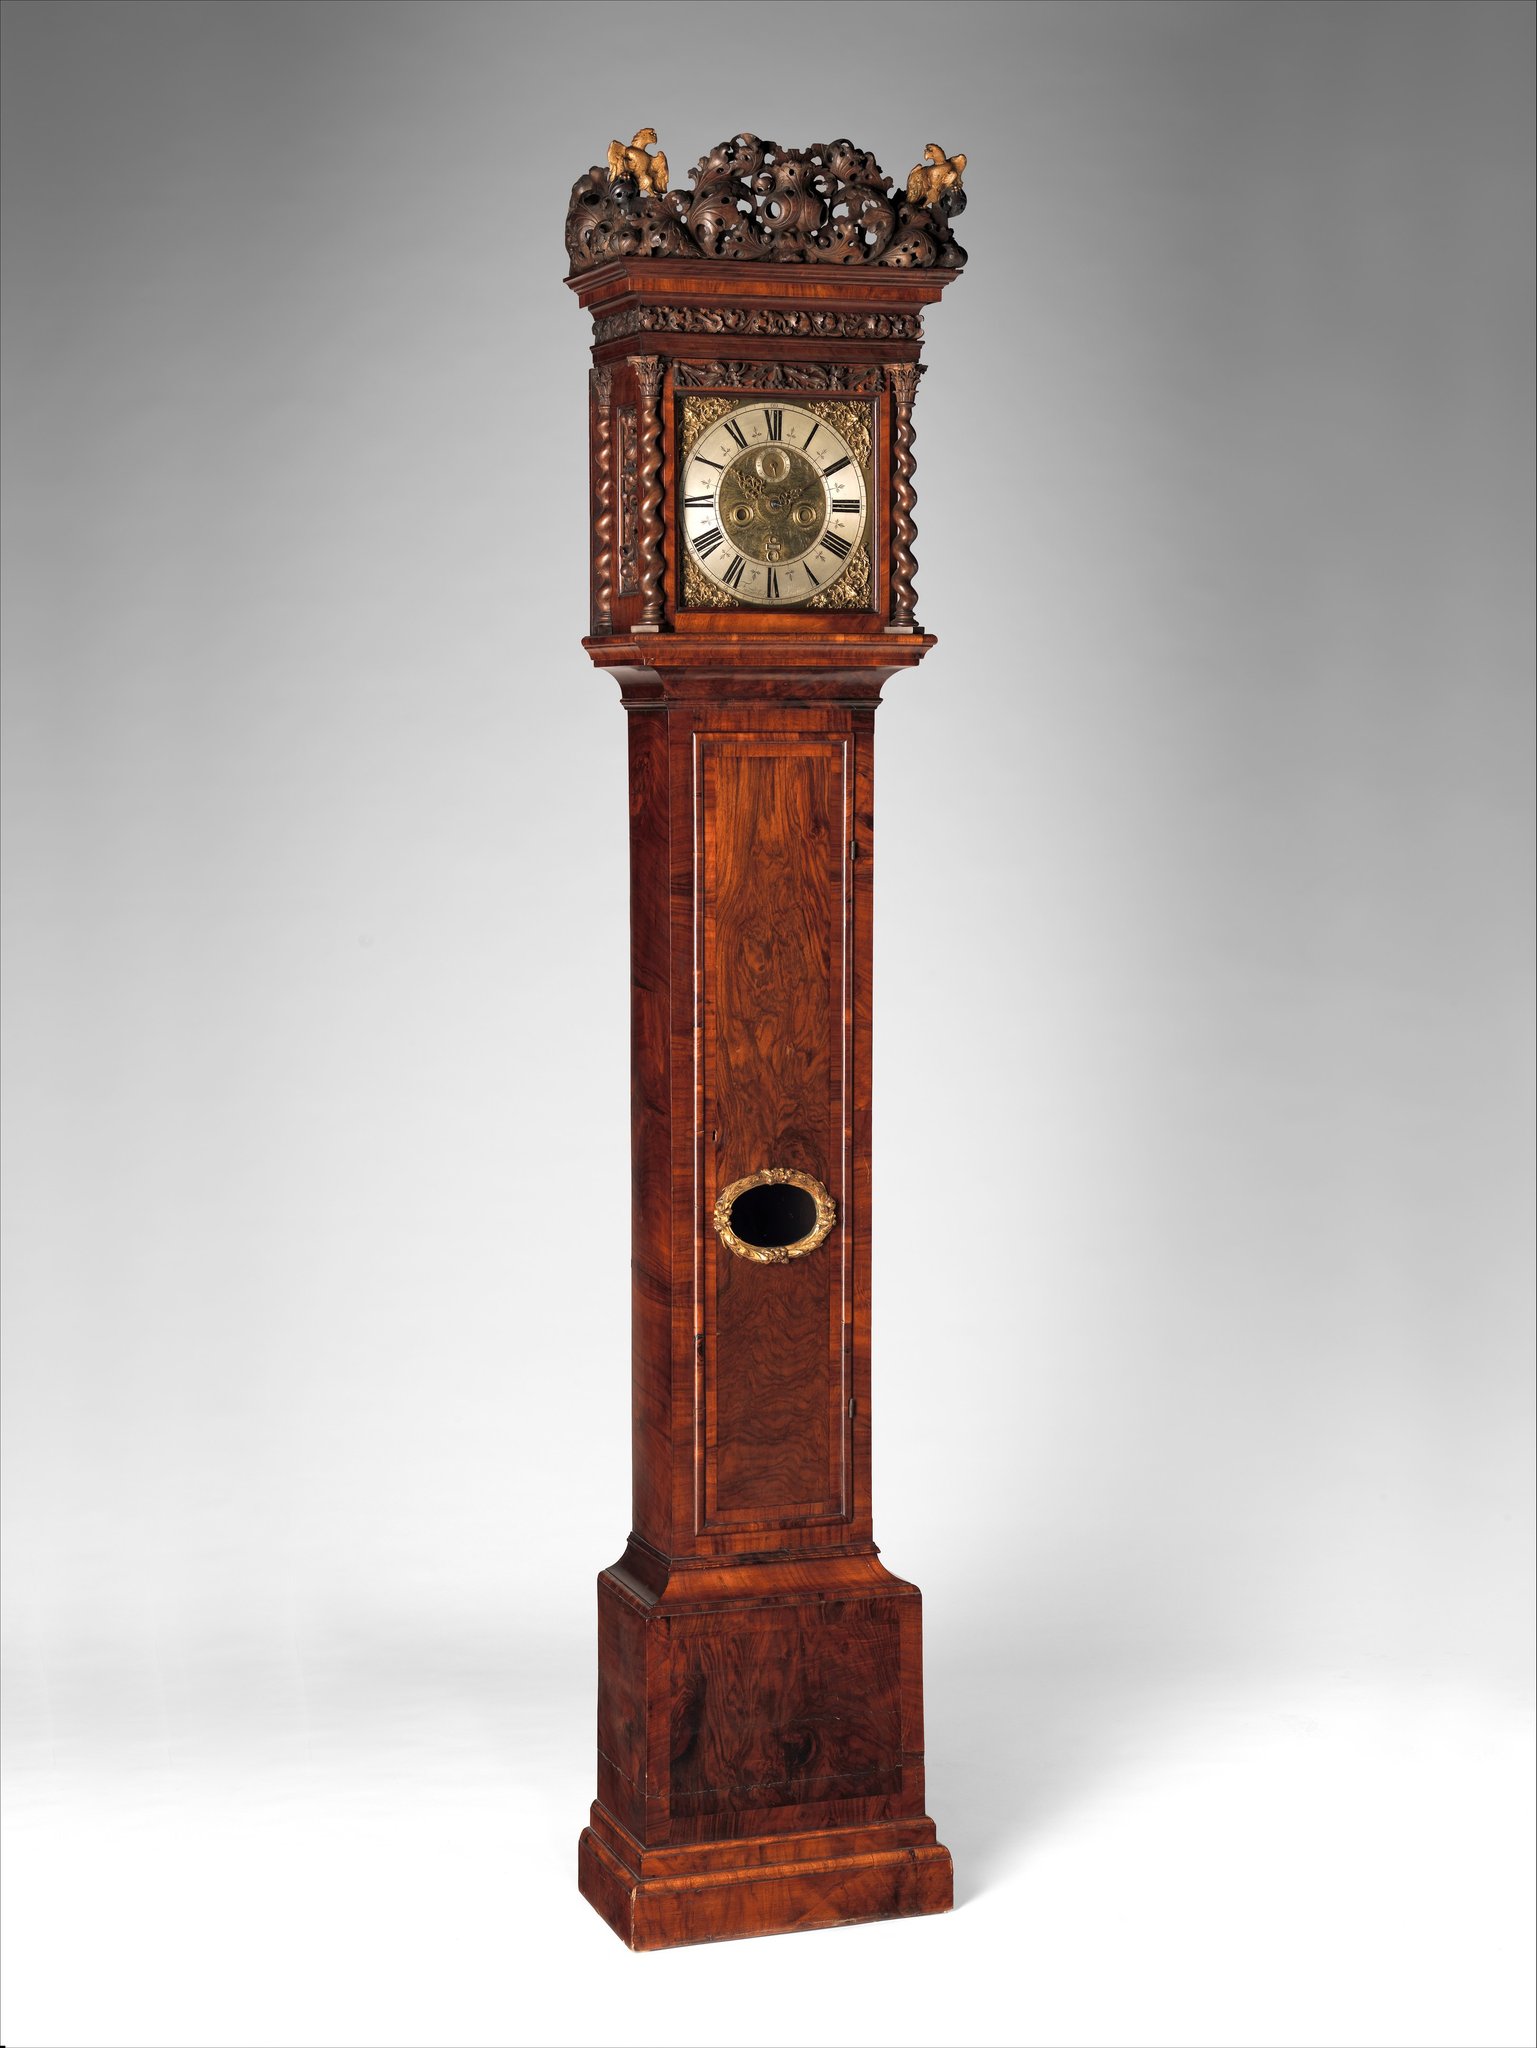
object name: longcase clock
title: Longcase clock with calendar and alarm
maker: ahasuerus ii fromanteel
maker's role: maker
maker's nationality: british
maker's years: 1640-1703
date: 1690-1694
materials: brass, wood, steel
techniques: gilding, silvered, veneering